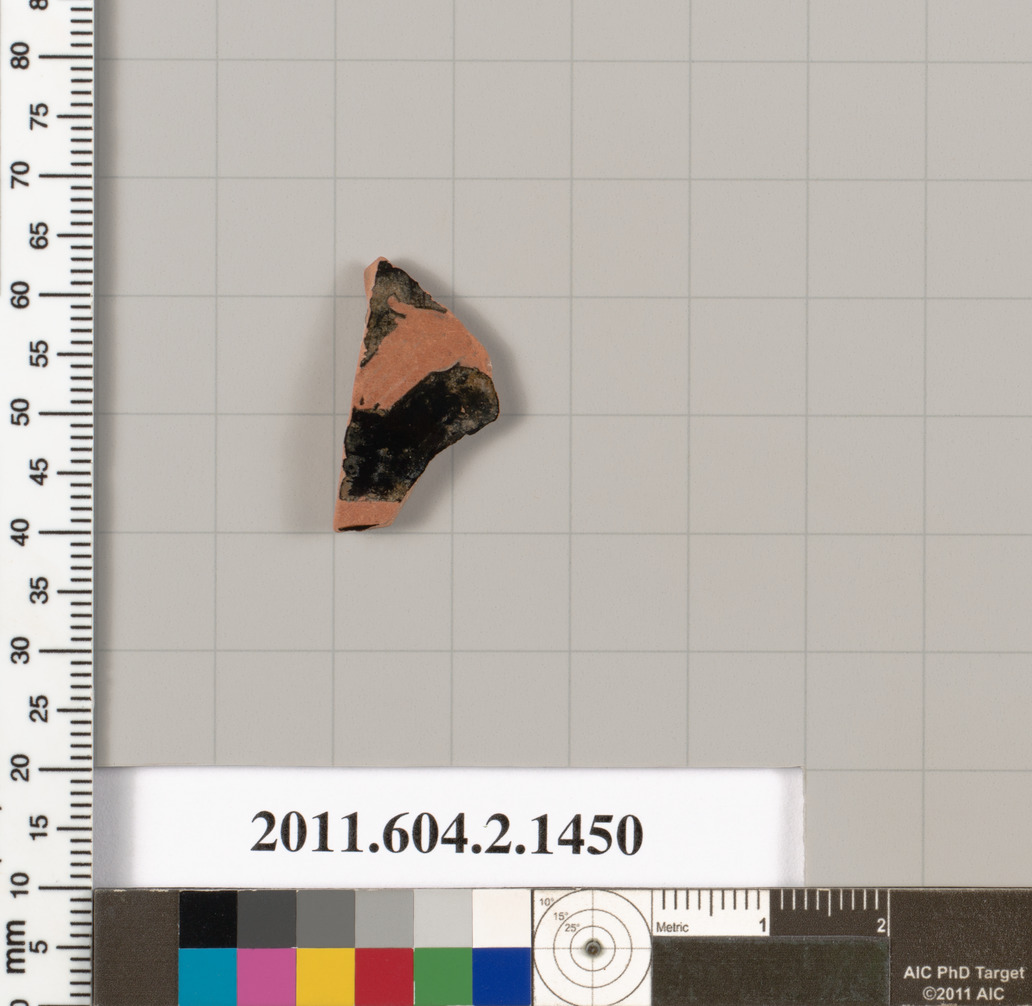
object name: skyphos fragment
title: Terracotta fragment of a skyphos (deep drinking cup)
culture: greek, attic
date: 425-401 BCE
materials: terracotta